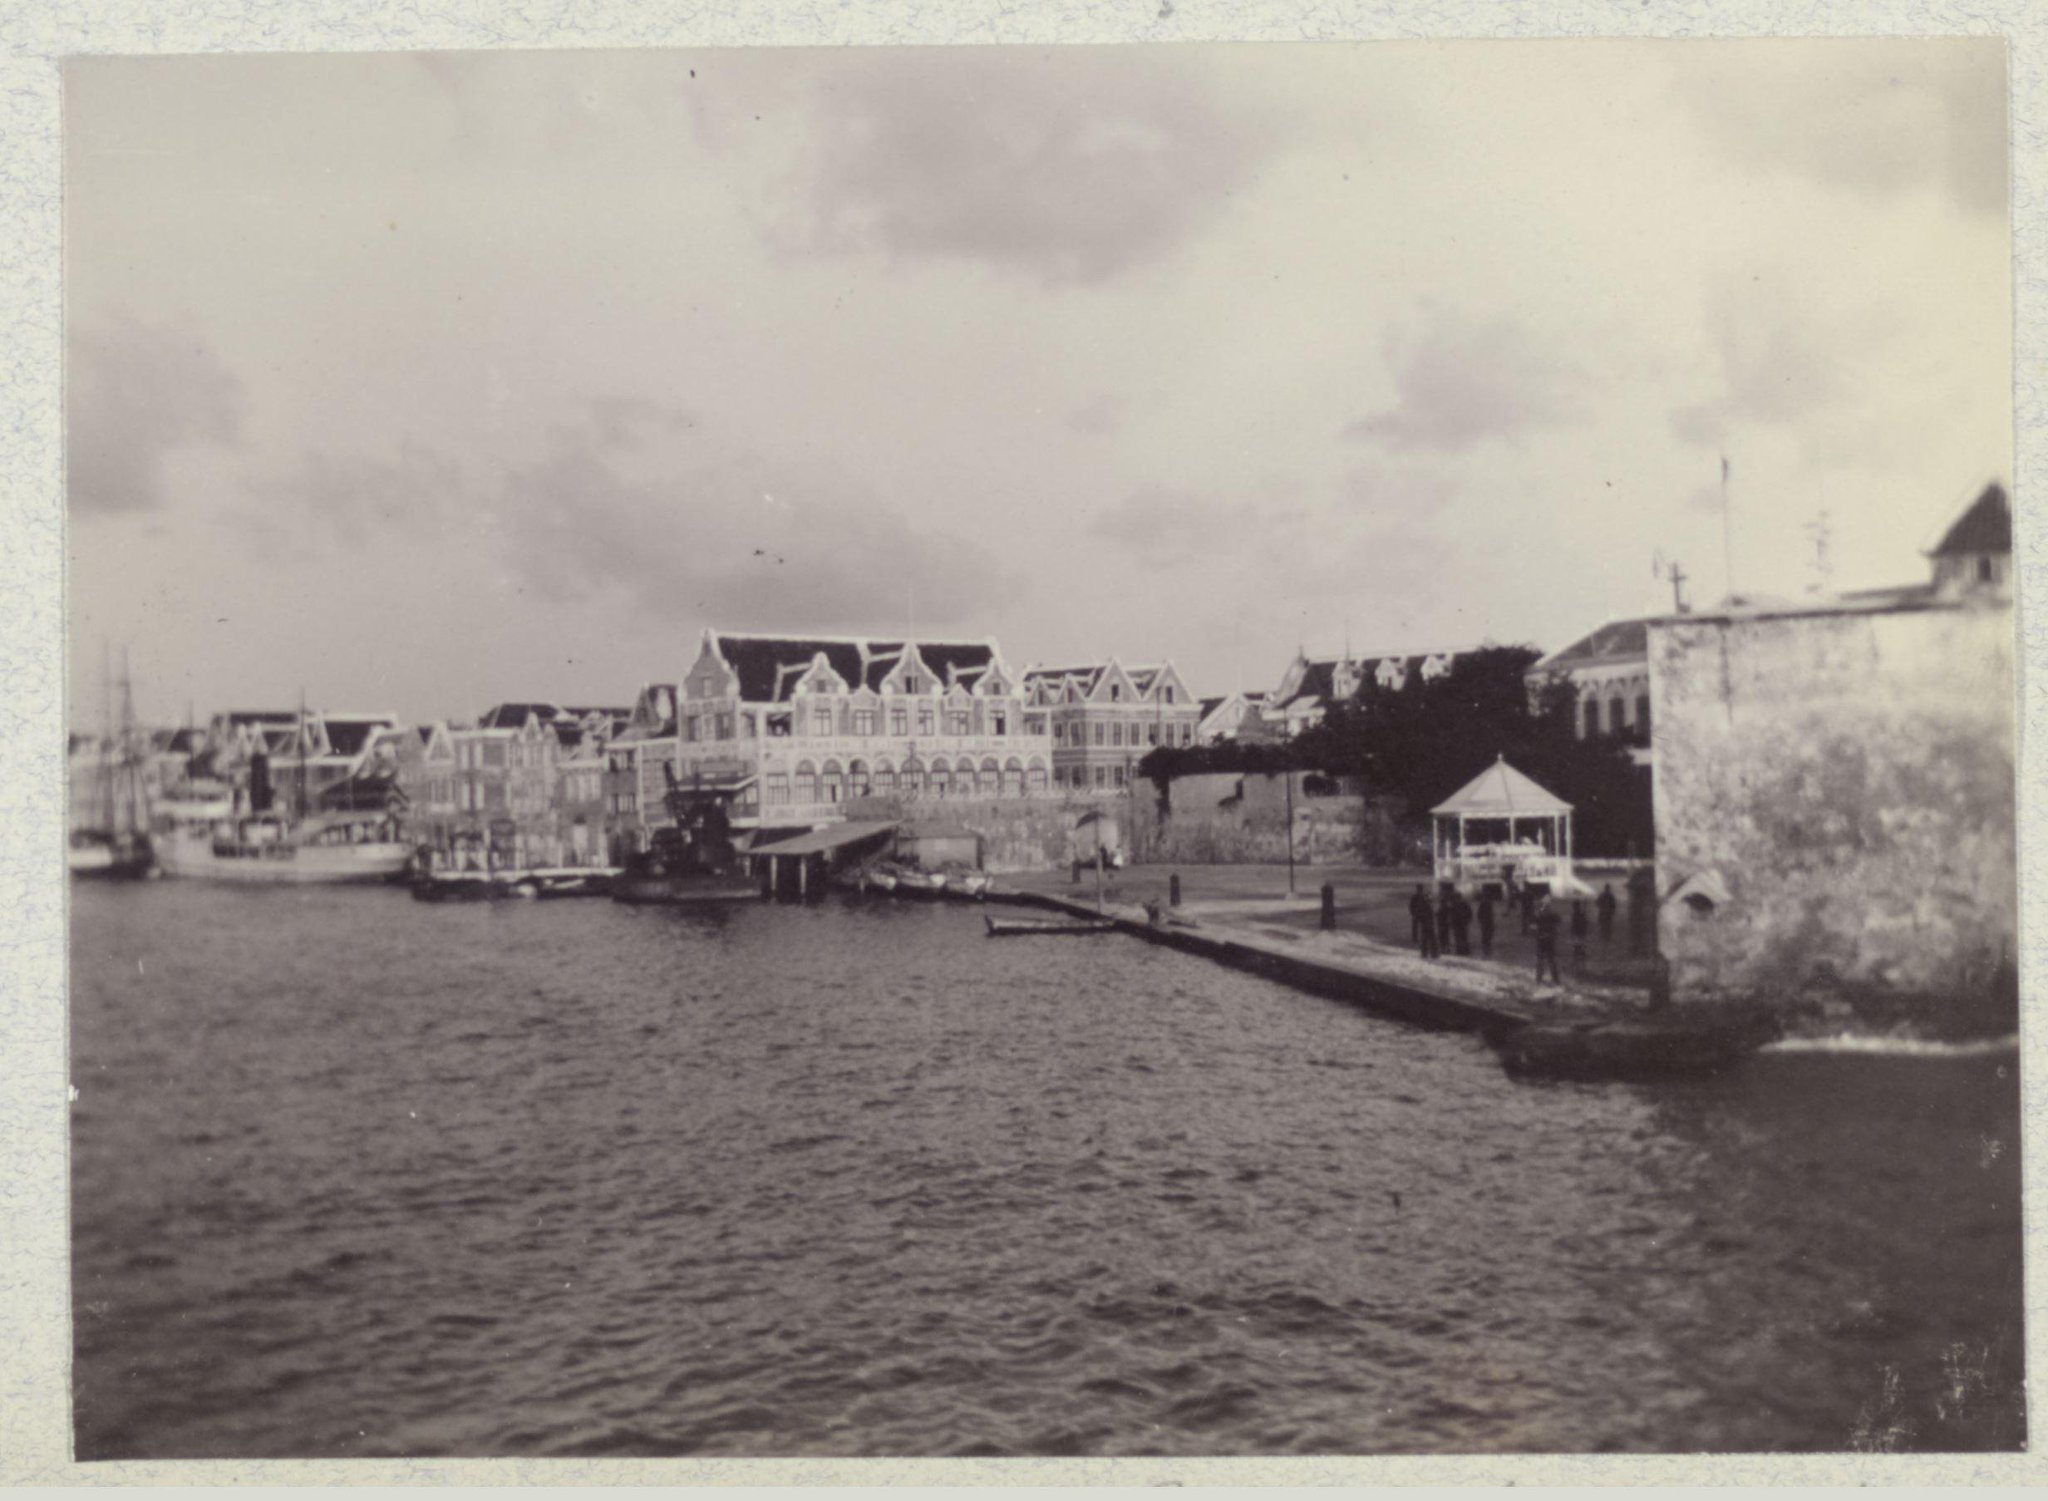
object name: photograph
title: Willemstad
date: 1902-1911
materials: photographic support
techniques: photography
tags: city-view in general; 'veduta'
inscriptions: inscription: ‘Gezicht op Curaçao met de "Prinses Juliana" aan de stadskade van 't kantoor. Febr. 1911’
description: Gezicht op huizen aan de Handelskade te Willemstad op Curaçao, februari 1911. Verderop aan de kade ligt het schip de 'Prinses Juliana'. Onderdeel van het fotoalbum van de familie Boom-Gonggrijp in Suriname en Curaçao.